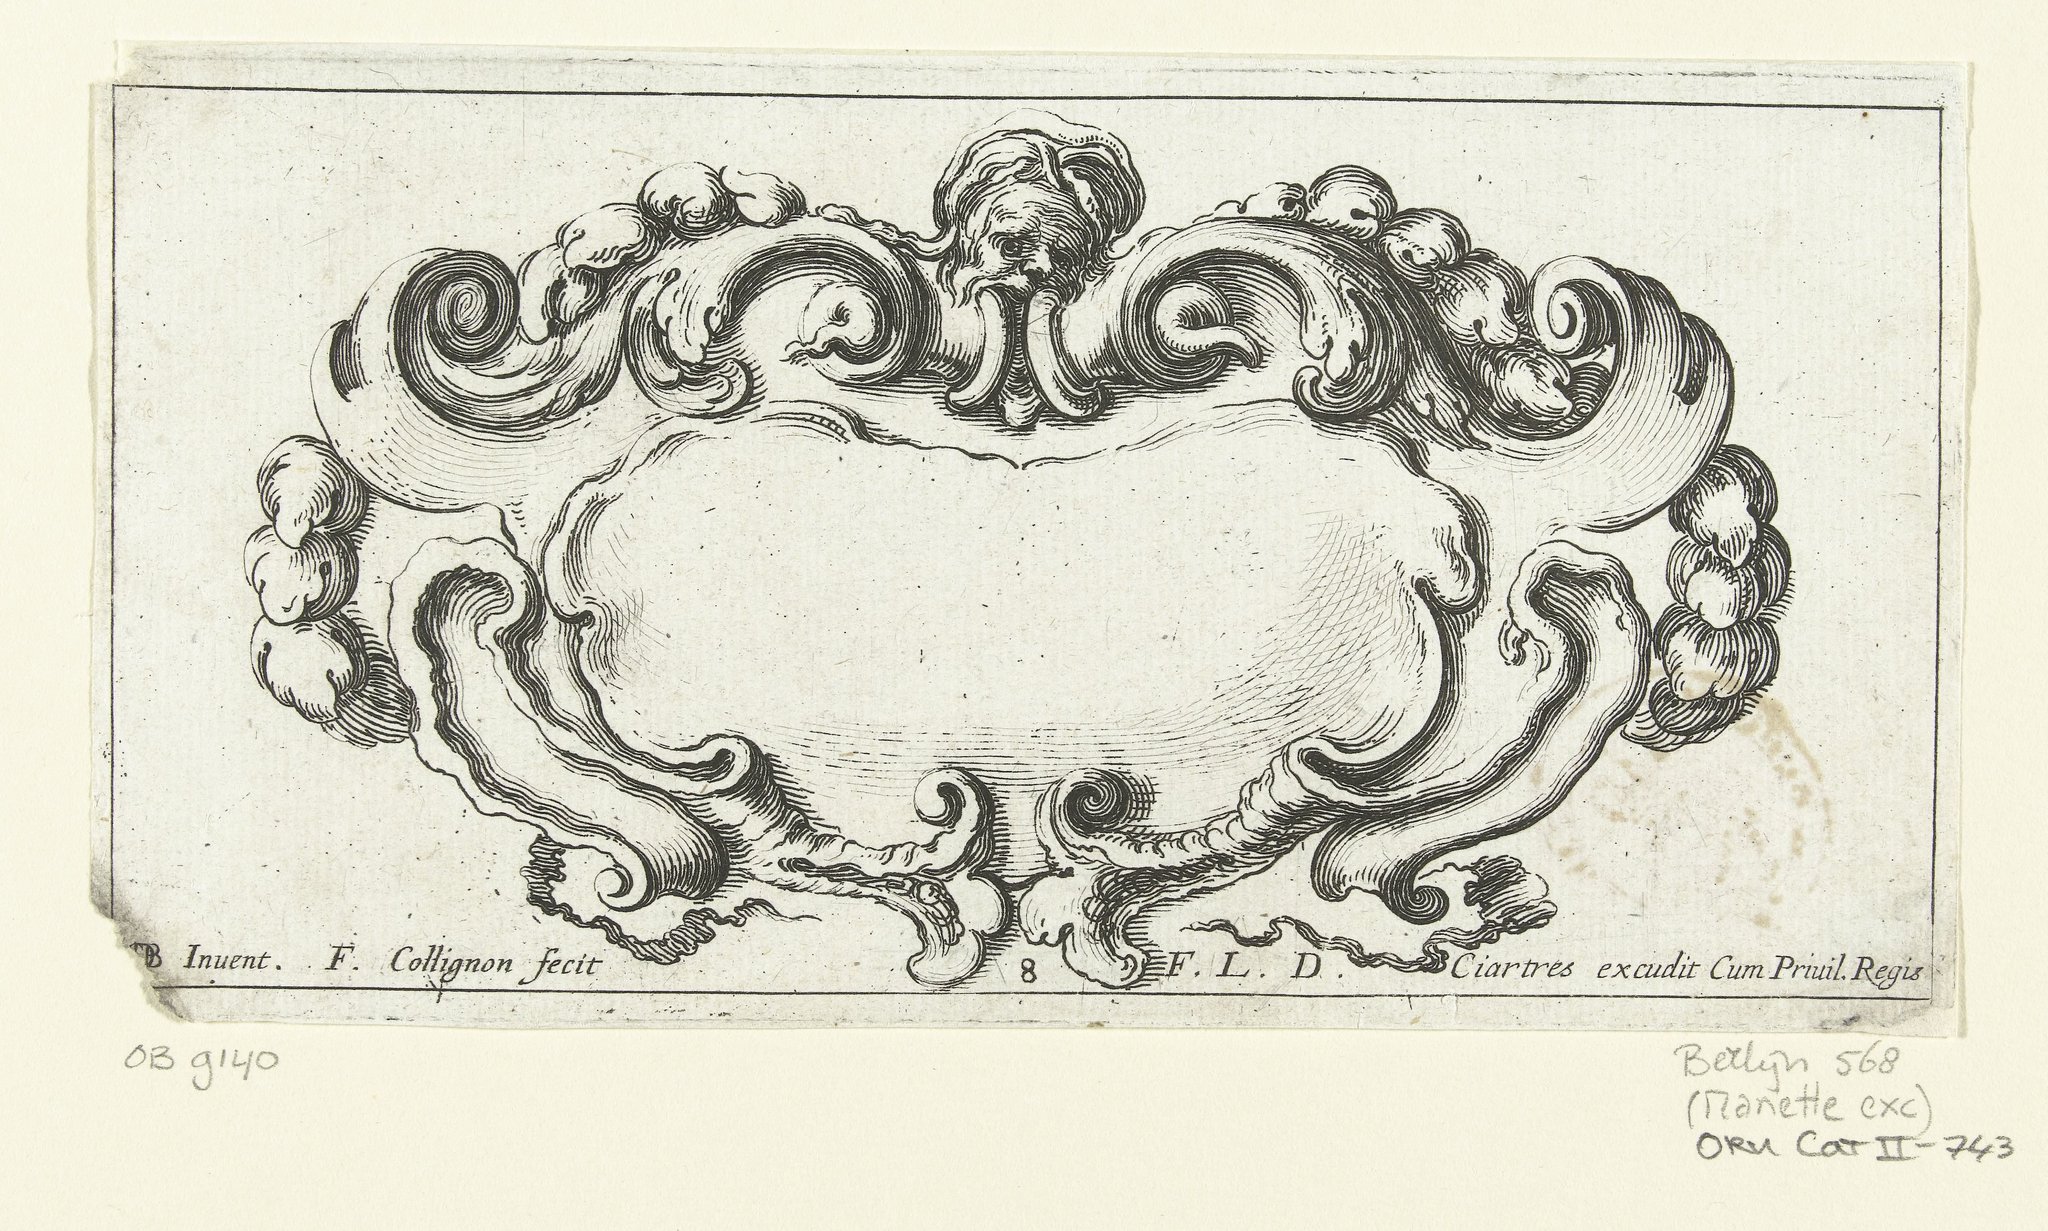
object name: print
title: Cartouche met hoofd van oude man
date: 1645-1647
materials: paper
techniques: etching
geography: france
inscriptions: collector's mark: Lugt 240